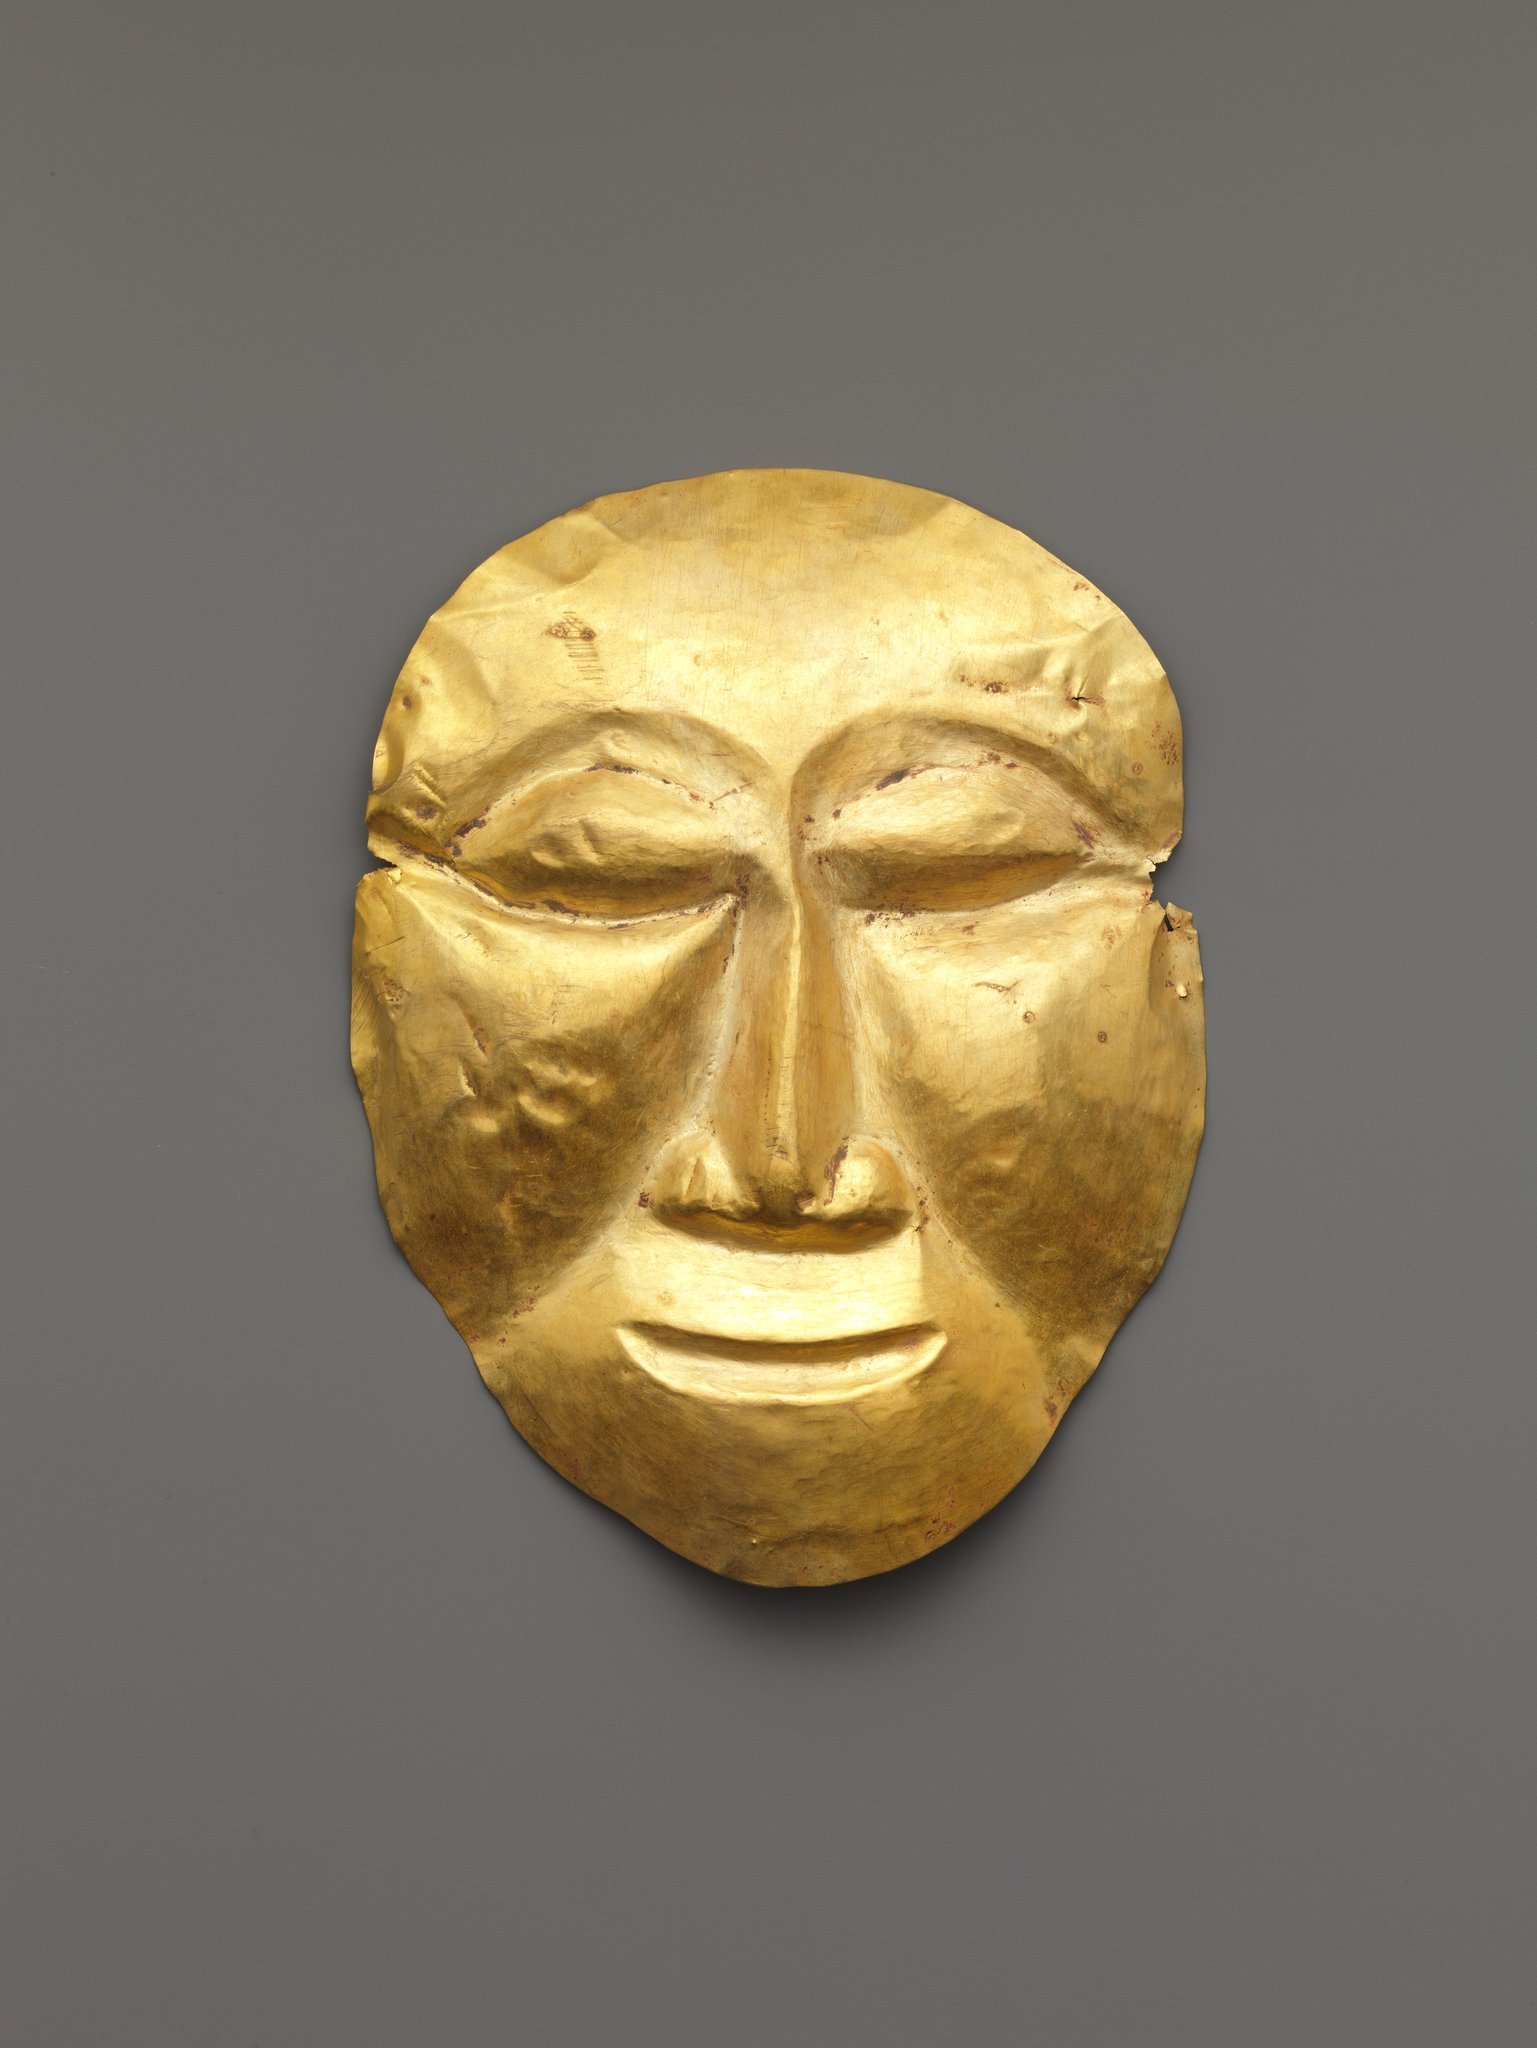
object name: mask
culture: indonesian, javanese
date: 701-833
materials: gold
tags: masks